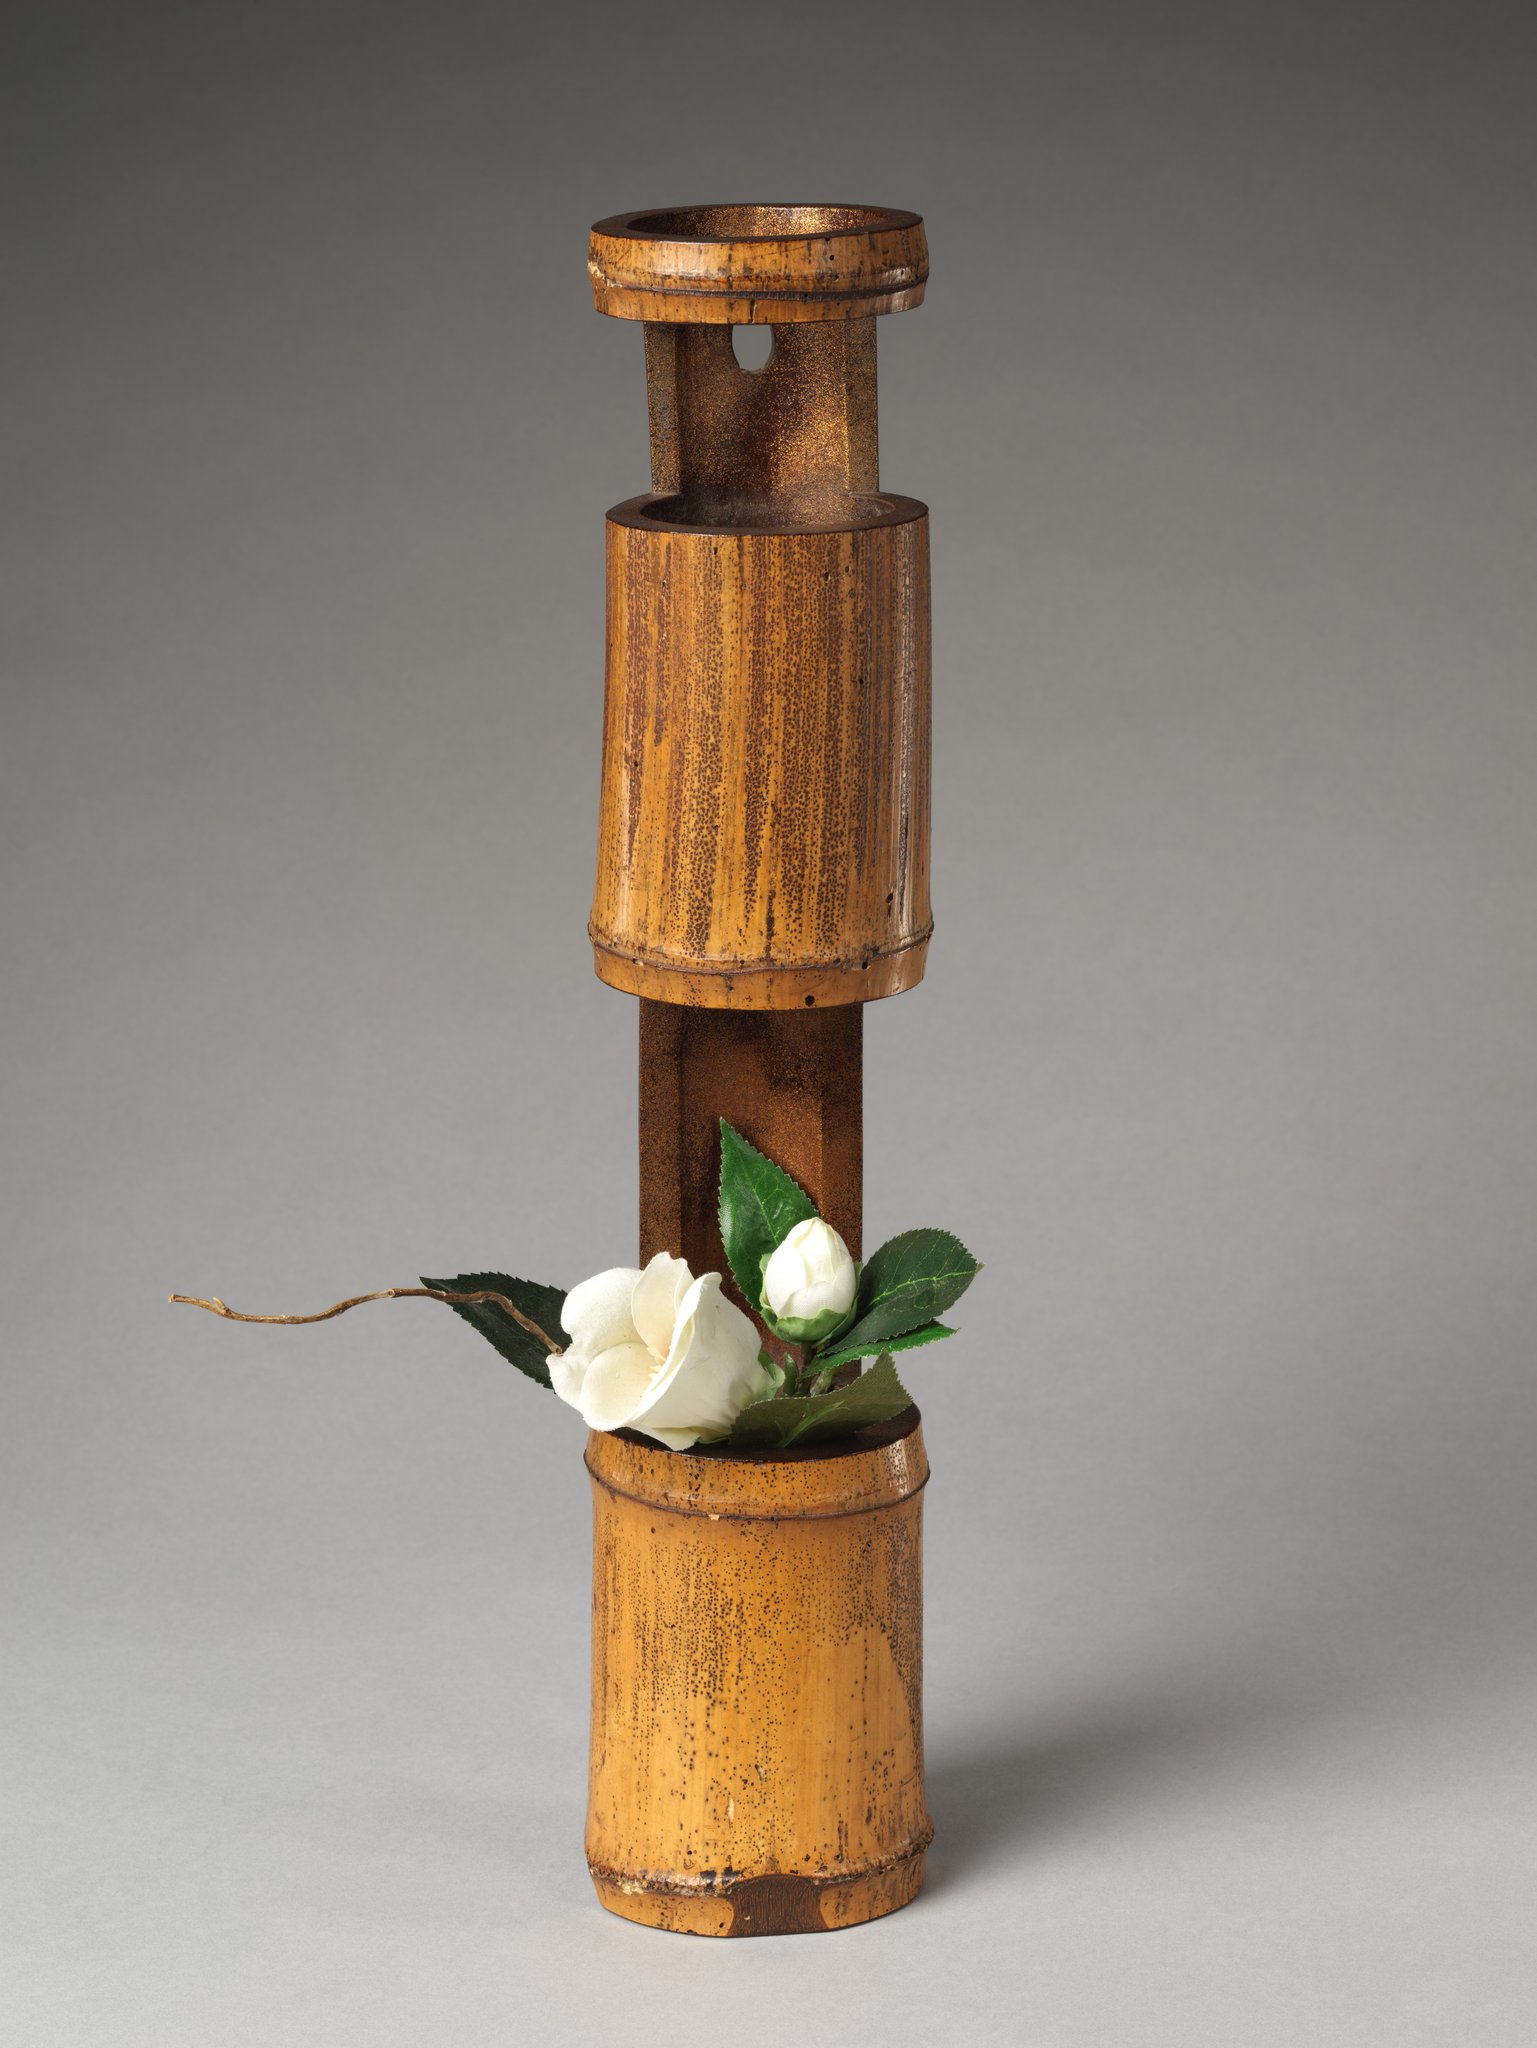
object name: flower container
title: Double-cut (Nijū-giri) Flower Container (Hanaire), named Cool Summer Morning (Shinryō)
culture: japanese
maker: kōgetsu sōgan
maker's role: artist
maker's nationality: japanese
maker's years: 1574-1643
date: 1601-1633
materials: bamboo, gold, lacquer